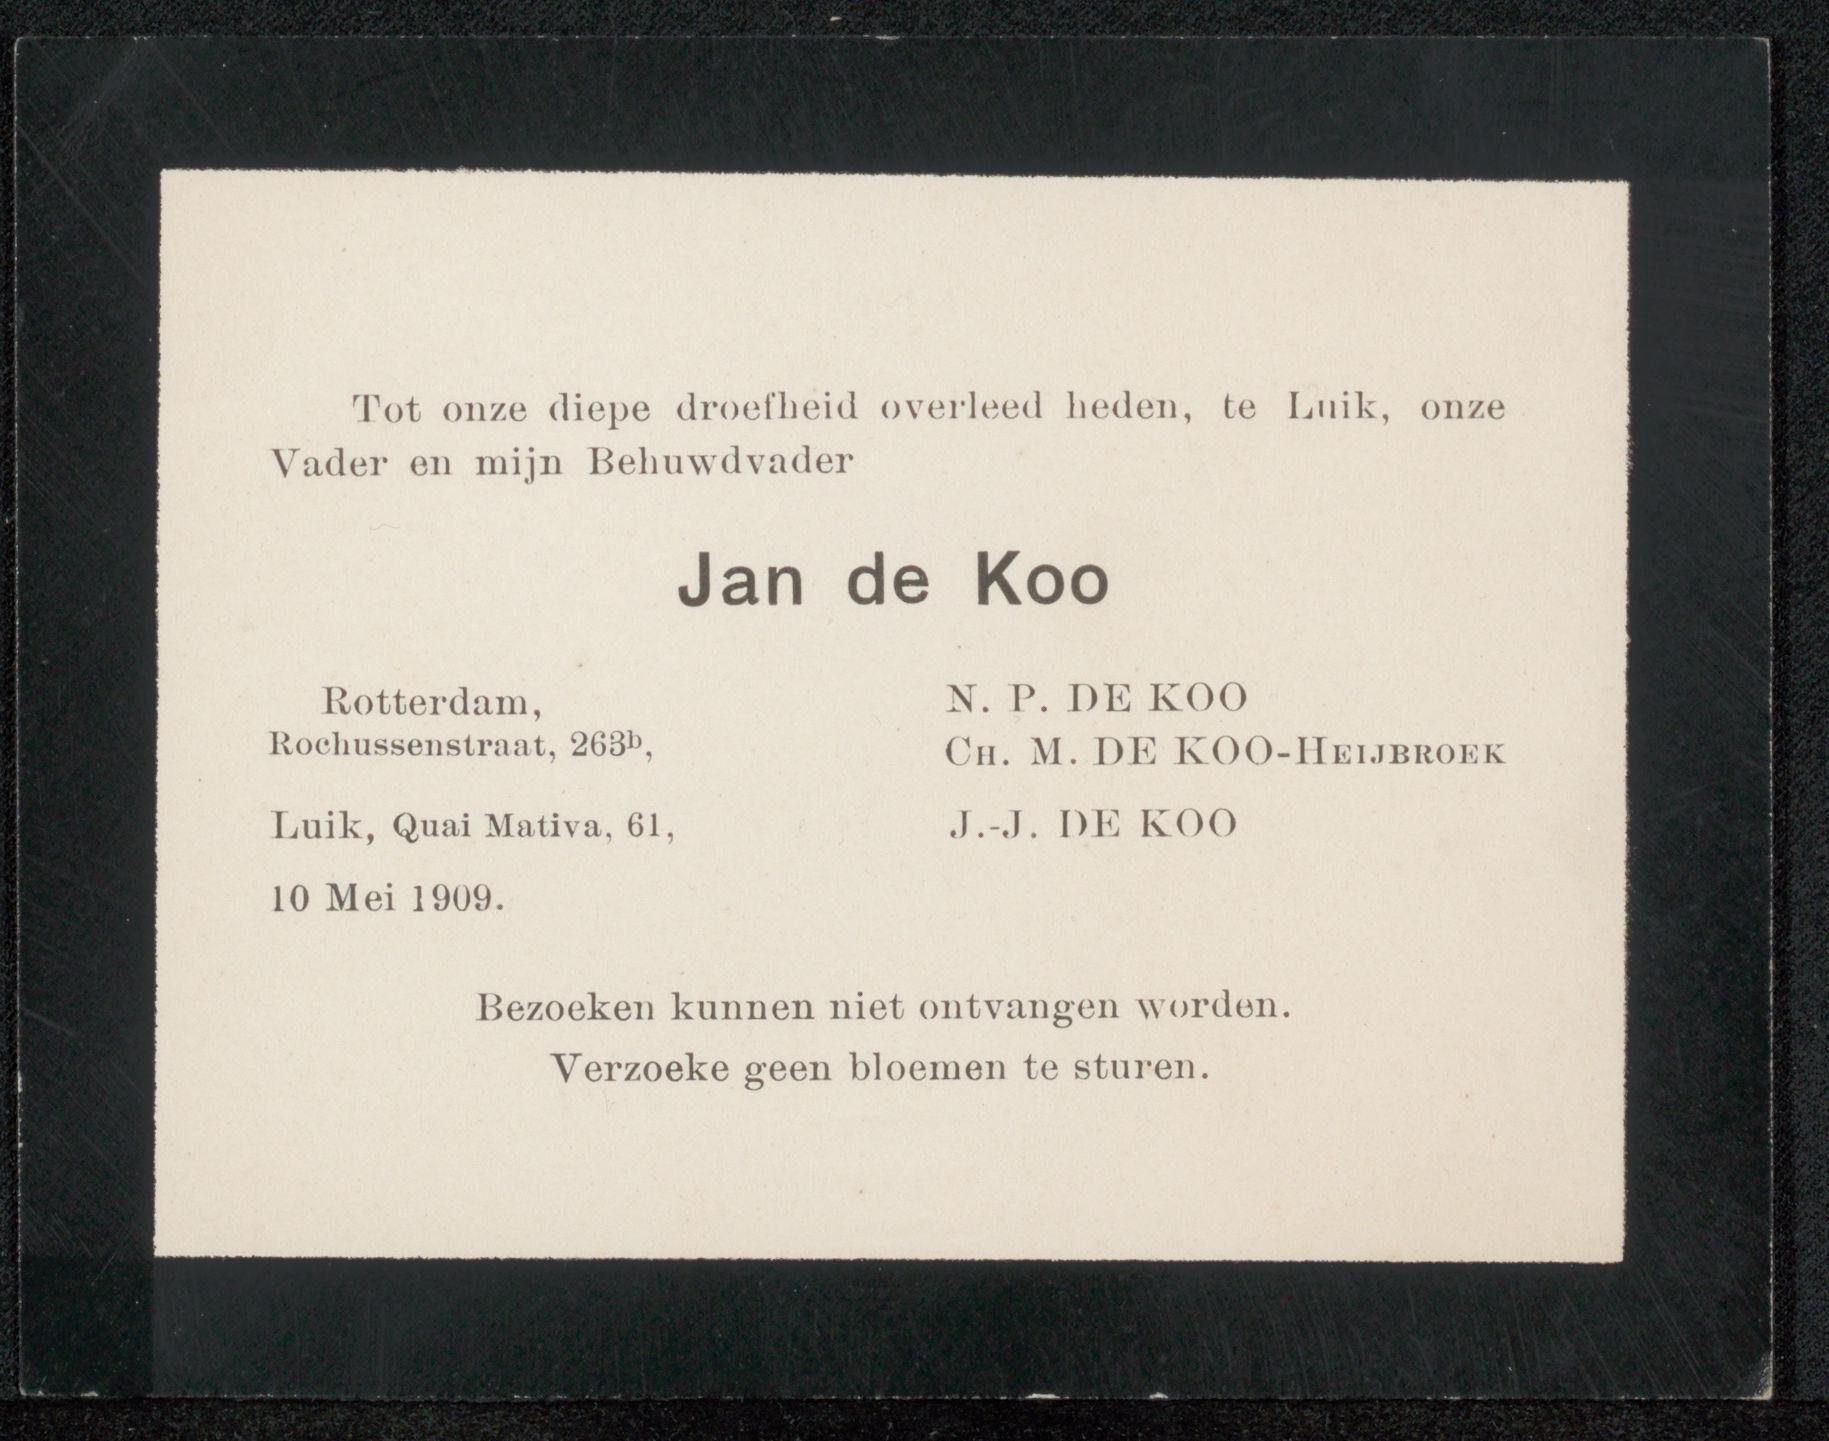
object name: overlijdensbericht, overlijdensadvertentie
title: Overlijdensbericht aan Philip Zilcken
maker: Anonymous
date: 1909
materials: paper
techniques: printing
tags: liège, johannes de koo, painter, draughtsman, philip zilcken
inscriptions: collector's mark: ‘RPK’